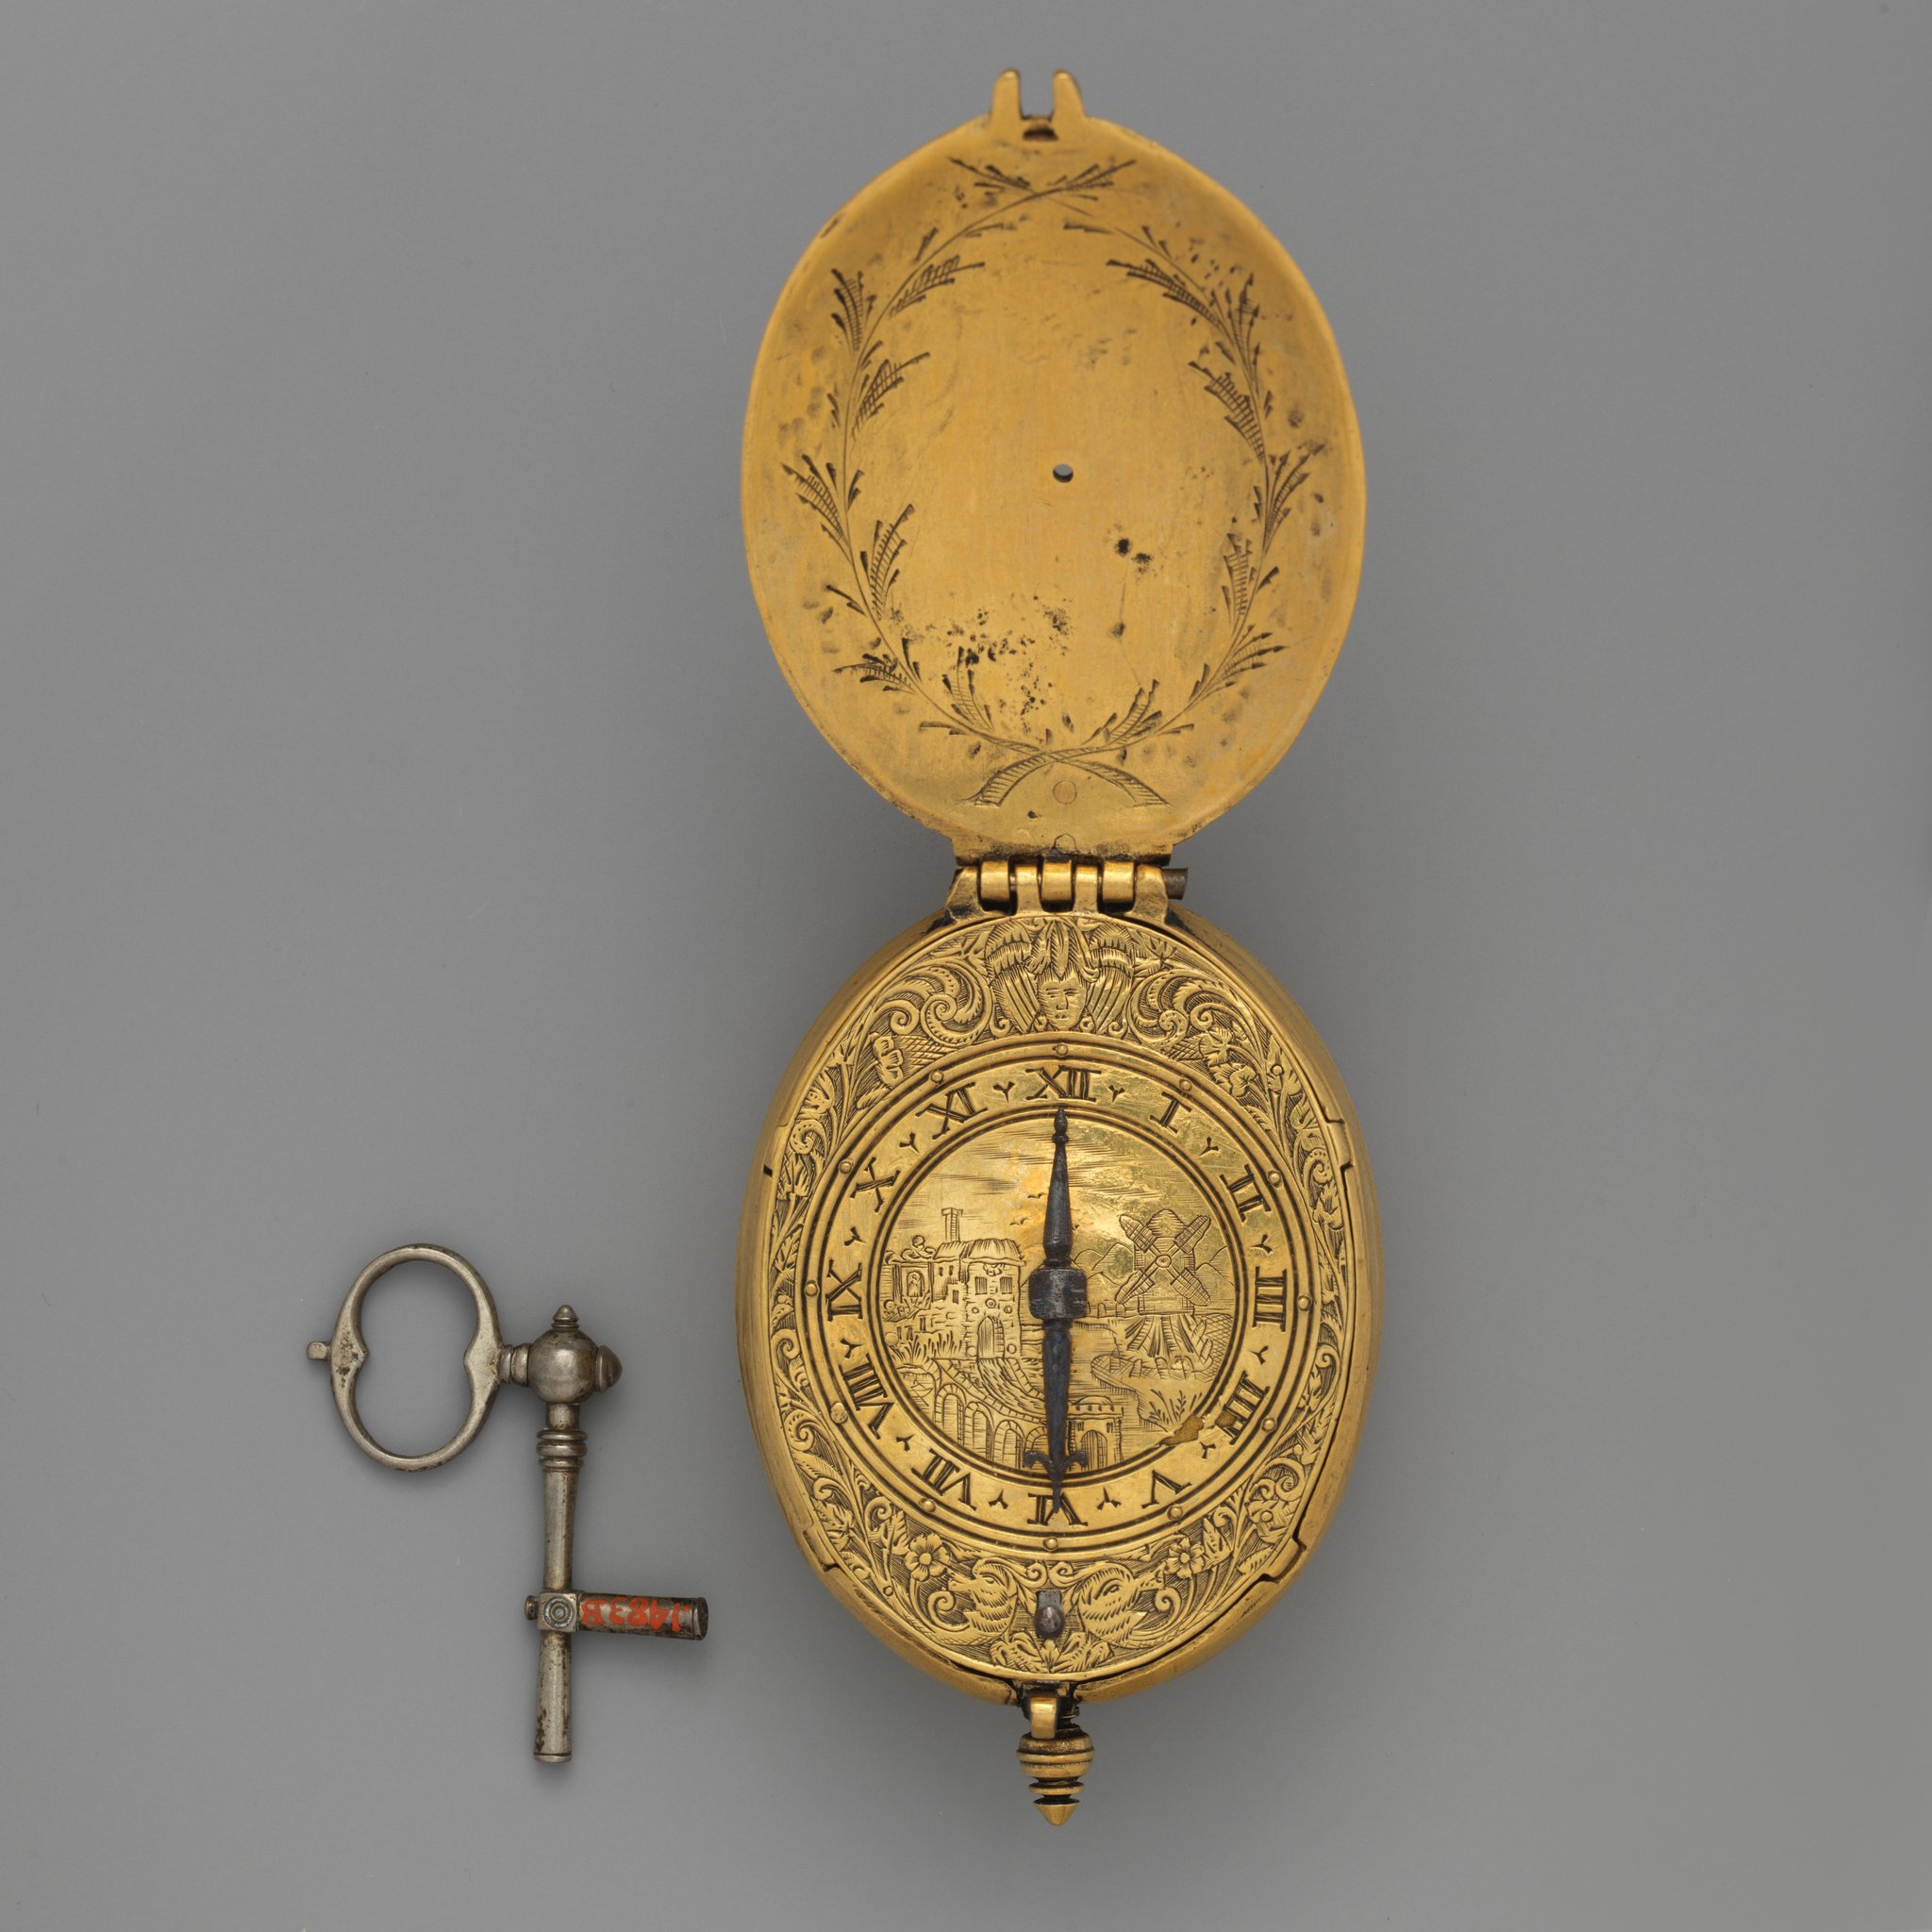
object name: watch with key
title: Watch and key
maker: john wright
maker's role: maker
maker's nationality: british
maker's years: 1620-1640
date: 1620-1640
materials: gilt brass, steel